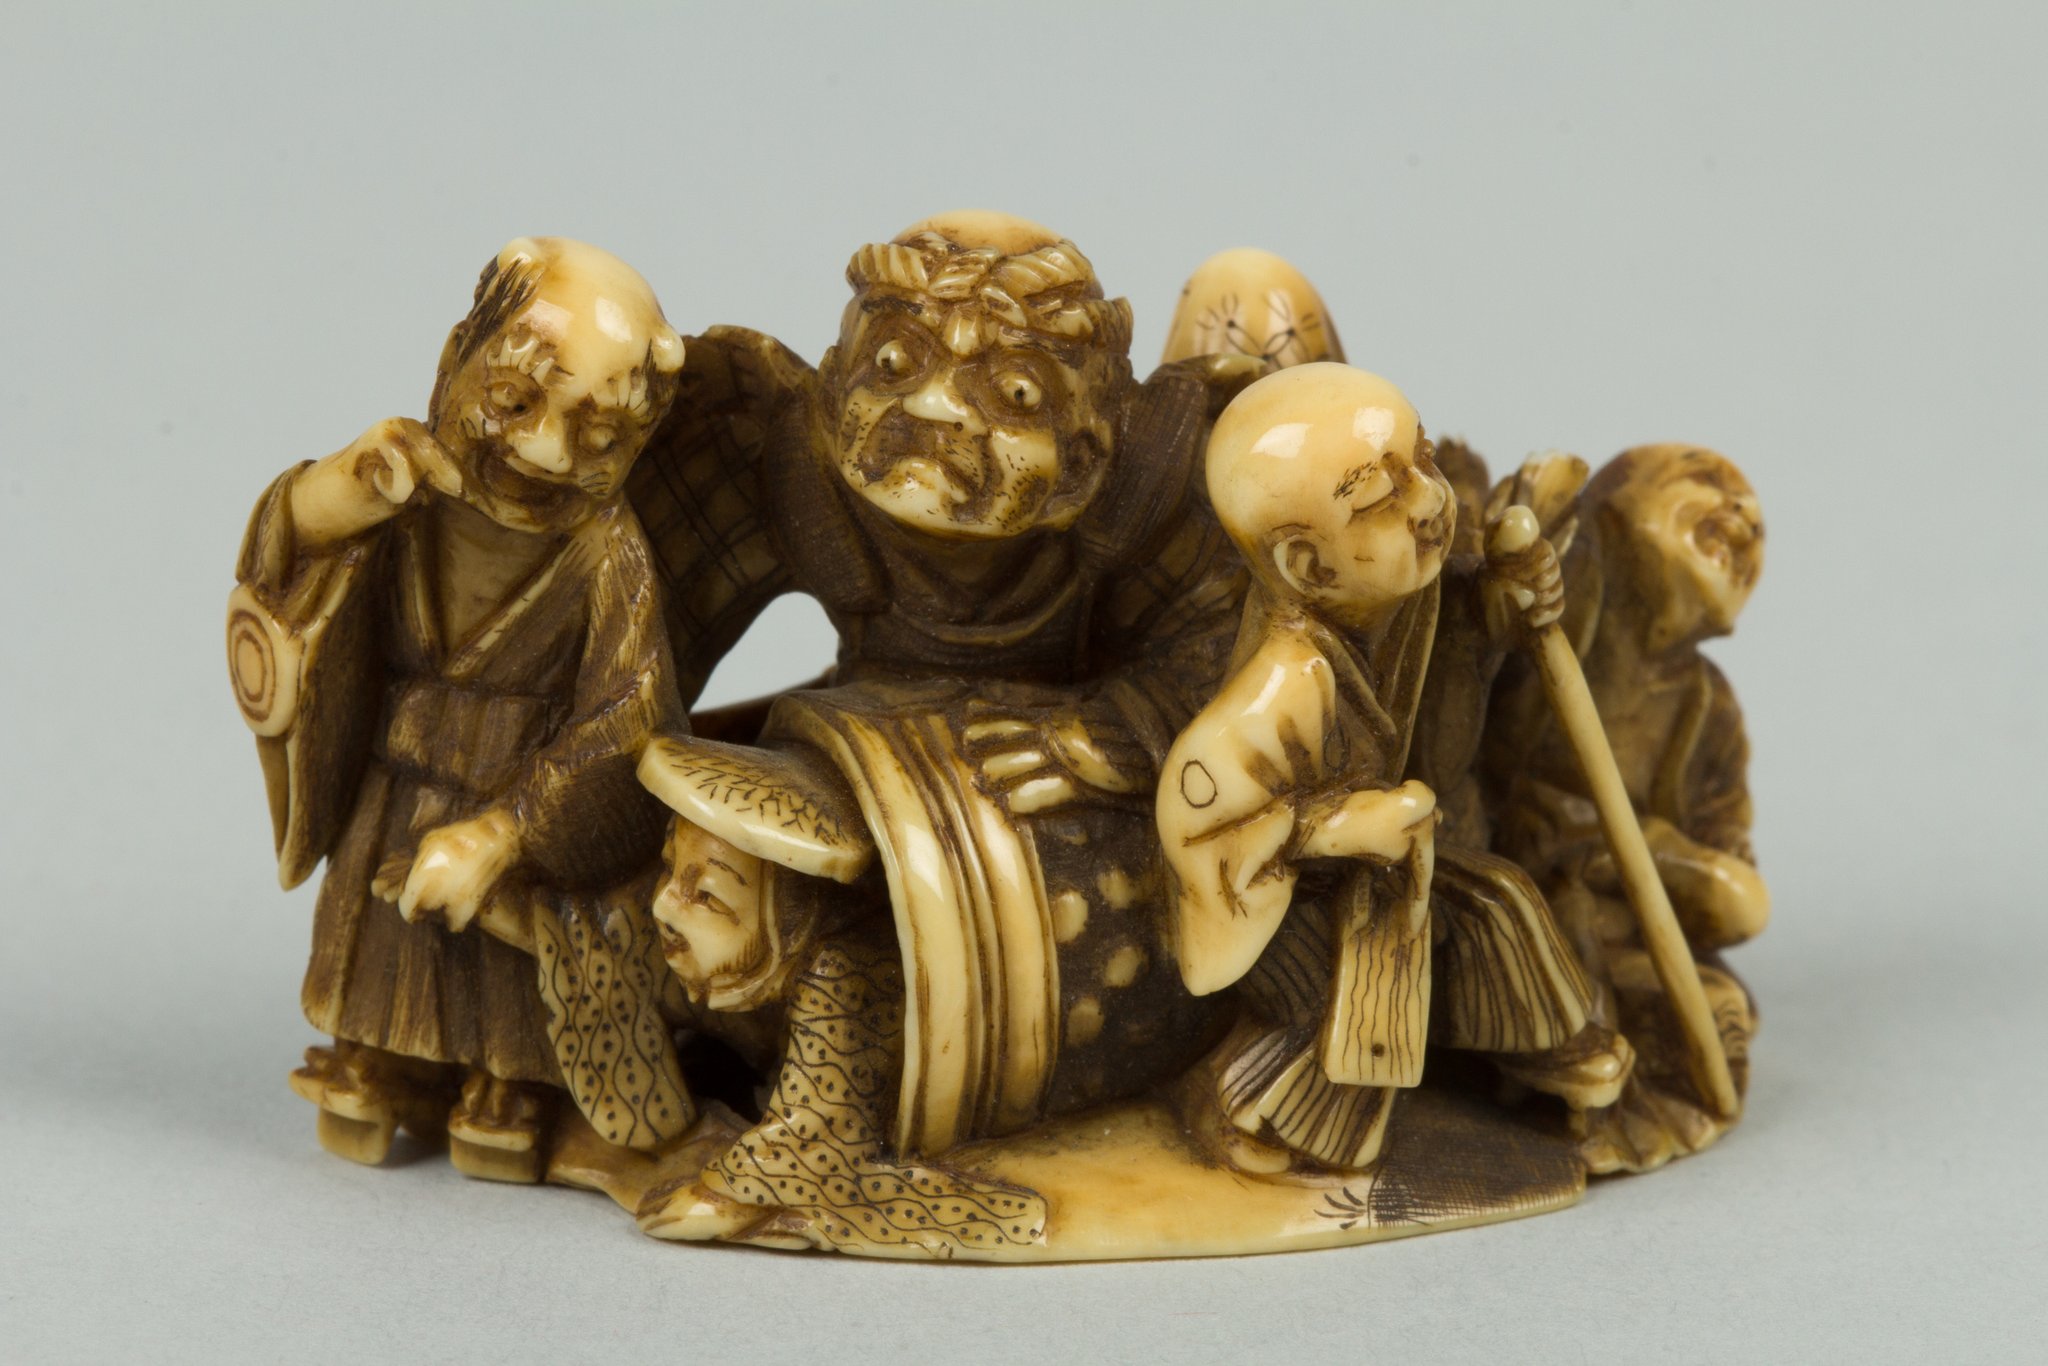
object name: netsuke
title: Netsuke with Group of Six Men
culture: japanese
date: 1801-1900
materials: ivory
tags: men